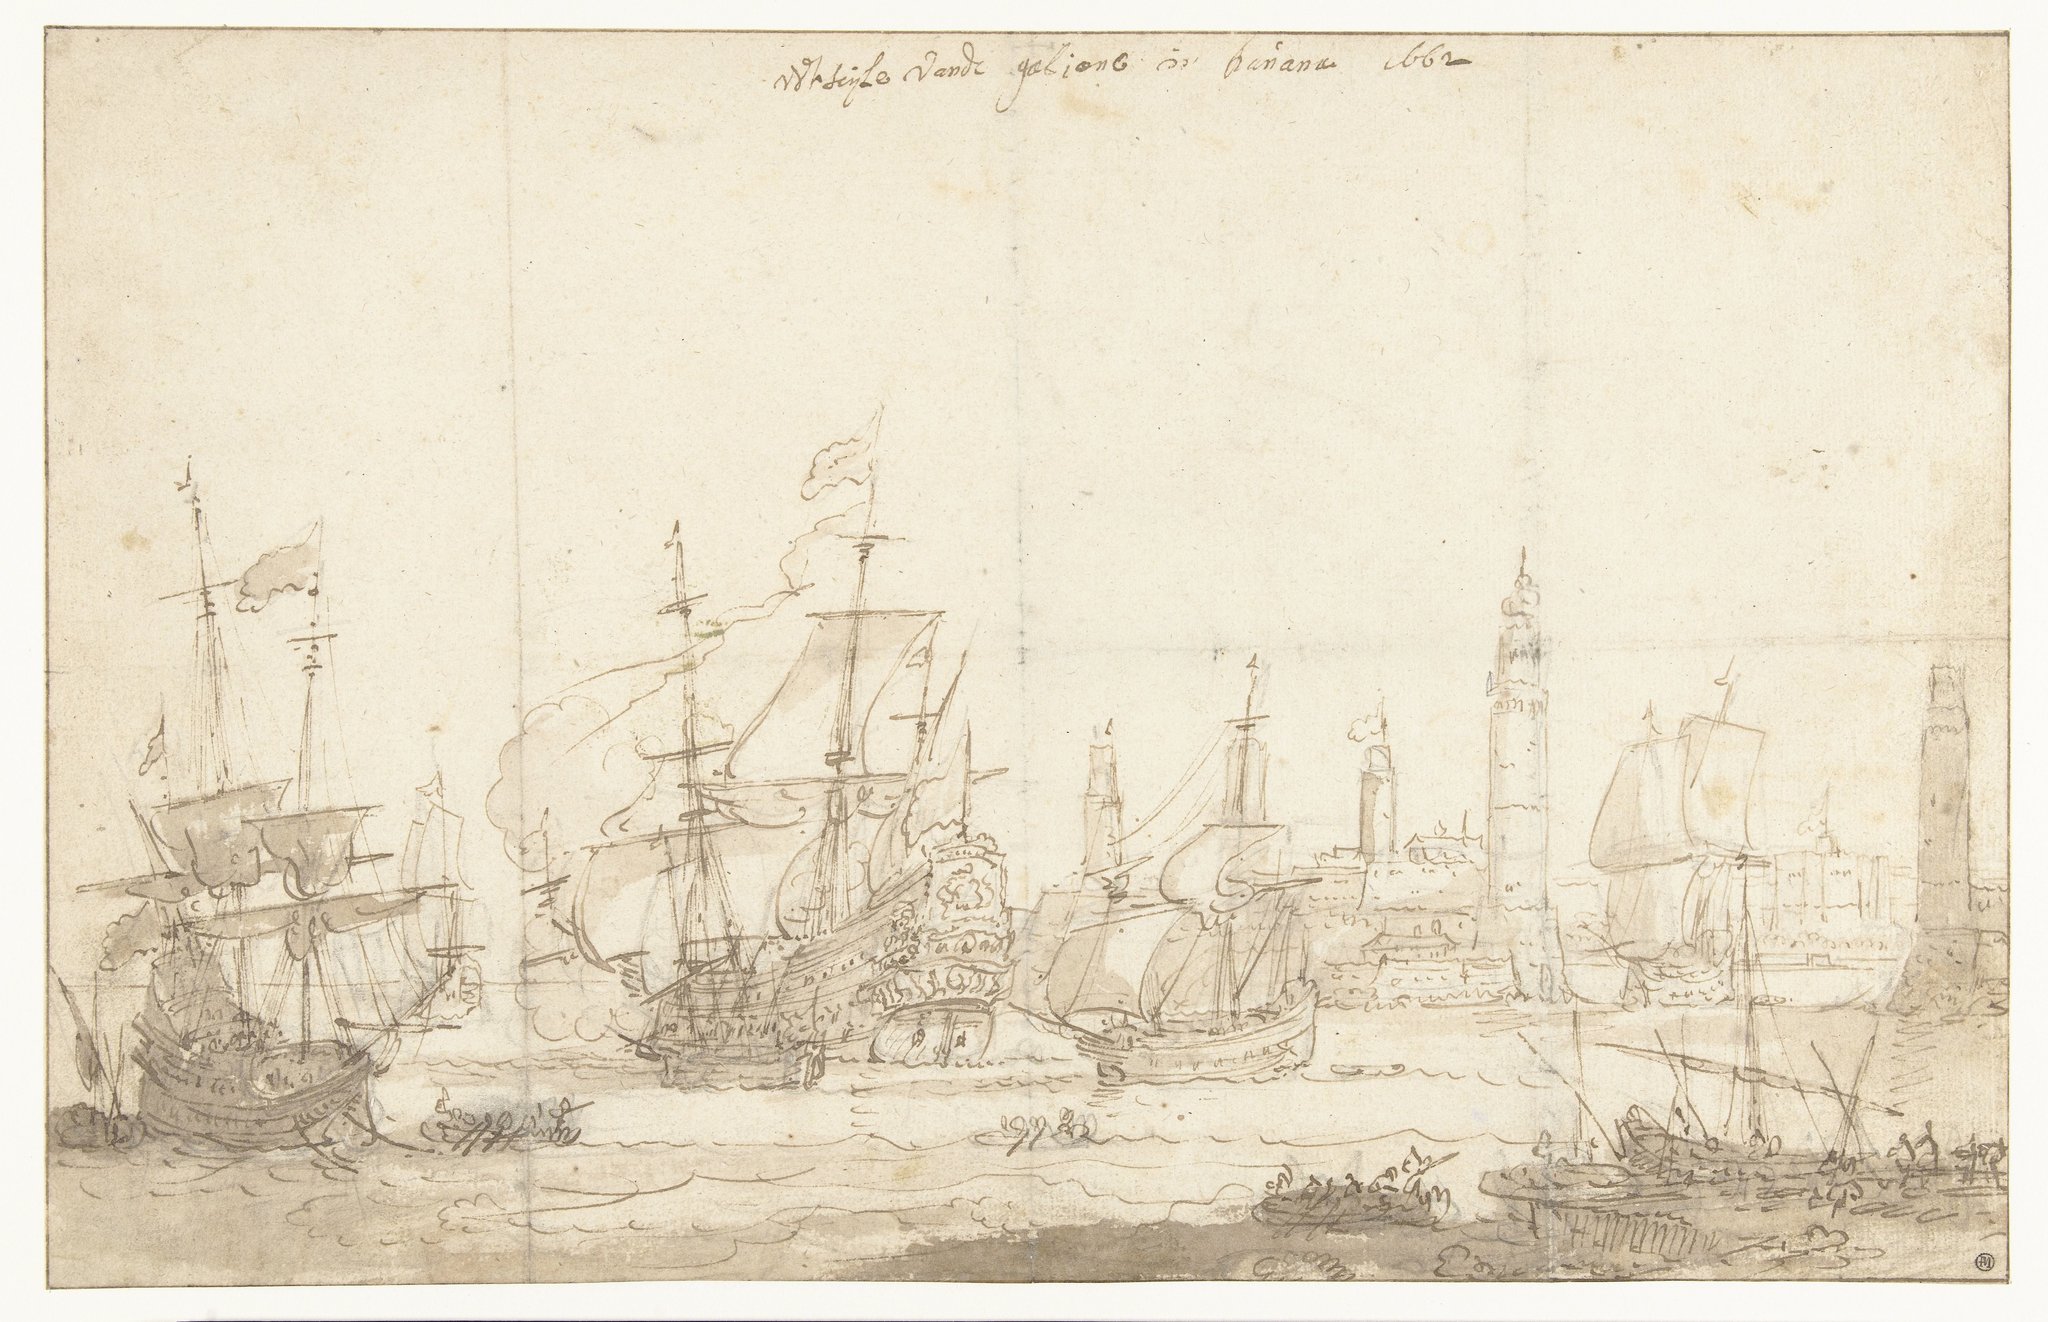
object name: drawing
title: Het uitzeilen van de Spaanse vloot van Havanna in 1662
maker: bonaventura peeters (i)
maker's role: draughtsman, painter, print maker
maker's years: 1614-1652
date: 1662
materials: chalk, ink, paper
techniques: brush, pen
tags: harbour, sailing-ship, sailing-boat, navy (+ sailing-ships)